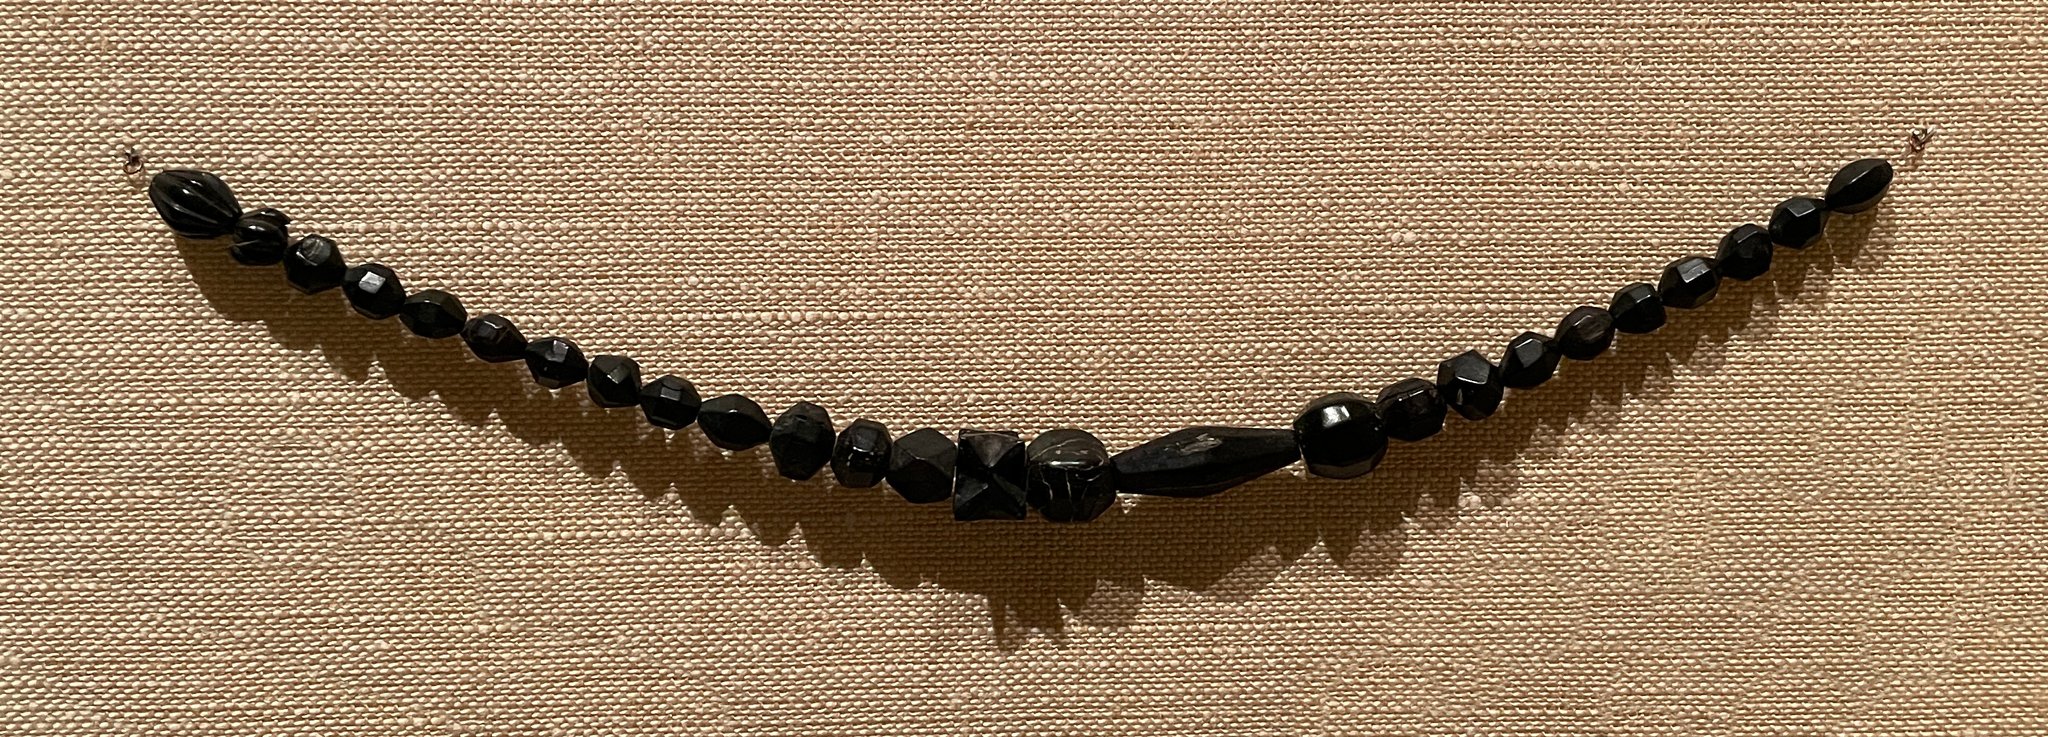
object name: bead, string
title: String of Beads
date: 701-1200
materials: stone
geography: iran